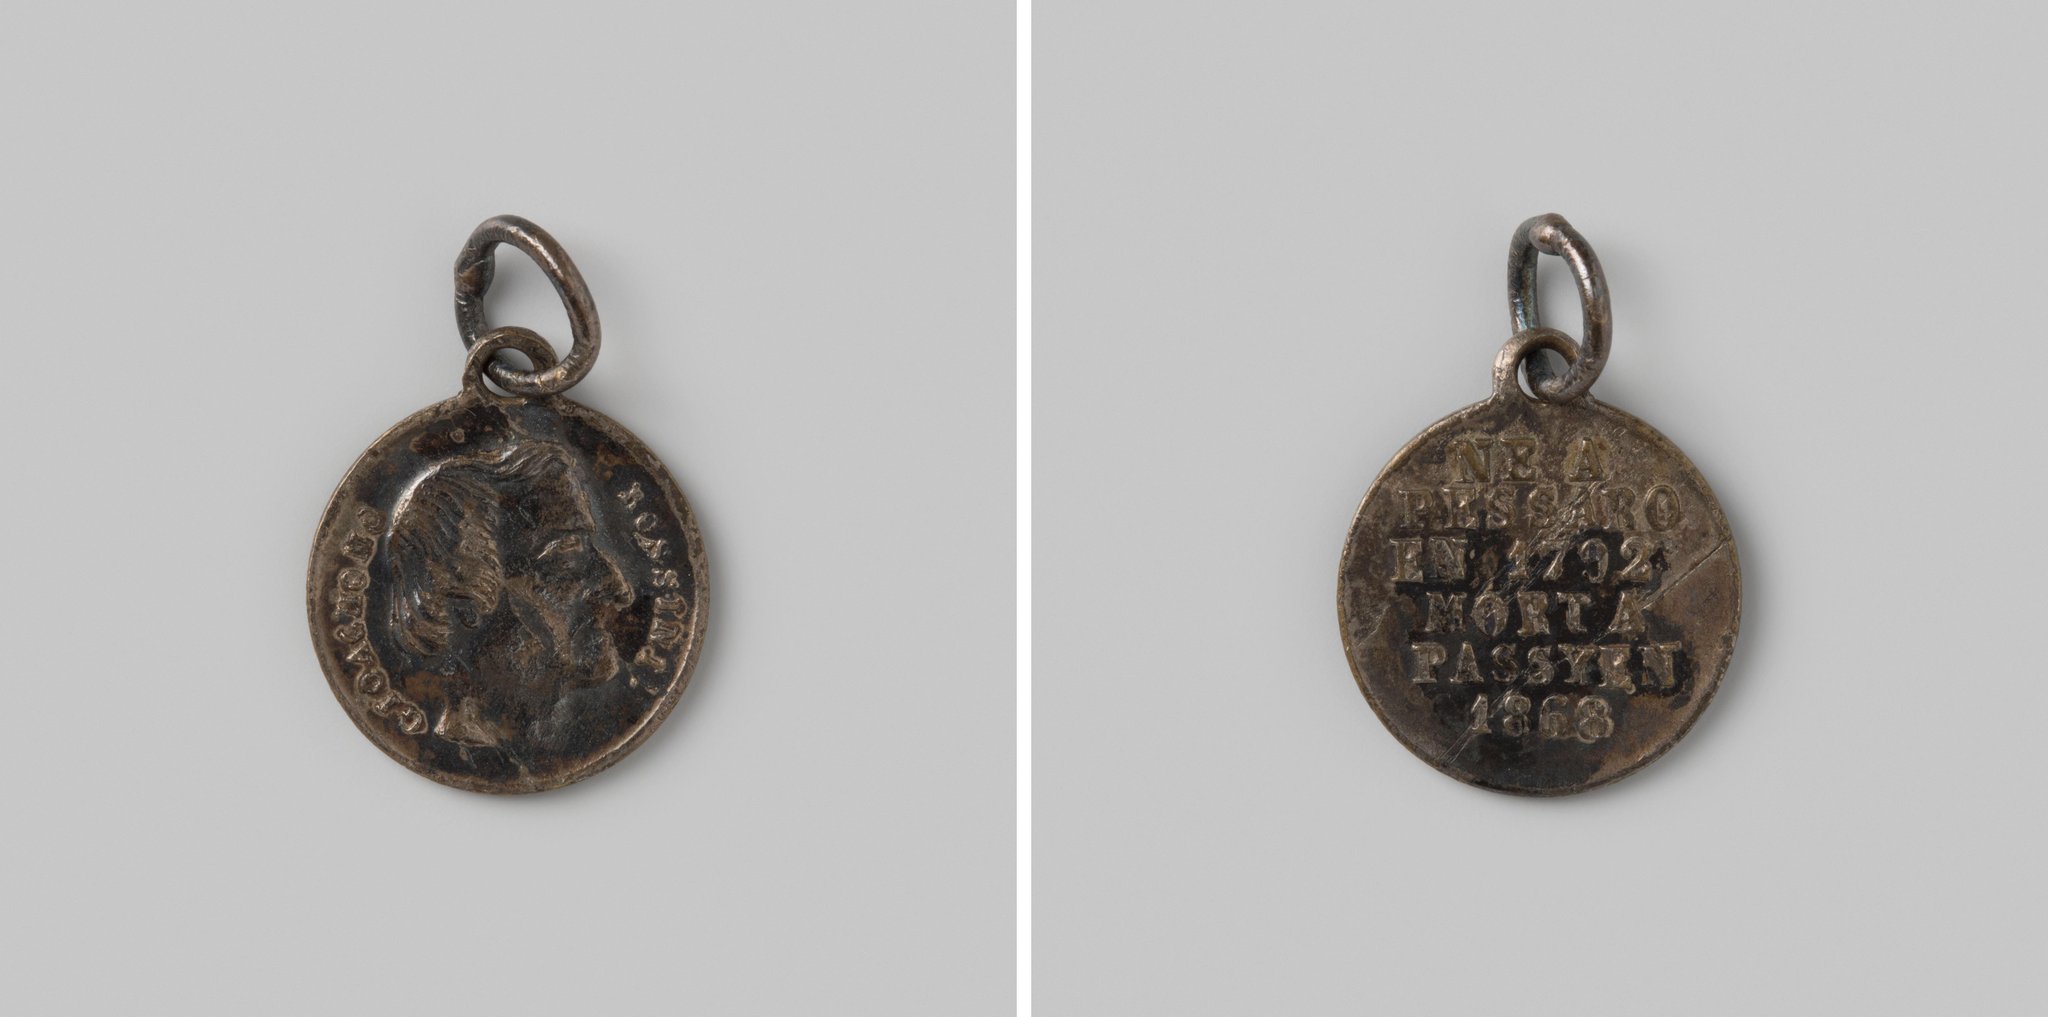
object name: history medal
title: Giaccomo Rossini 1792-1868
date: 1868-1900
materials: brass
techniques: striking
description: Klein verzilverd messing penninkje met oog en draagring, op de voorzijde het portret van Rossini naar rechts met omschrift, op de keerzijde zes regels tekst.